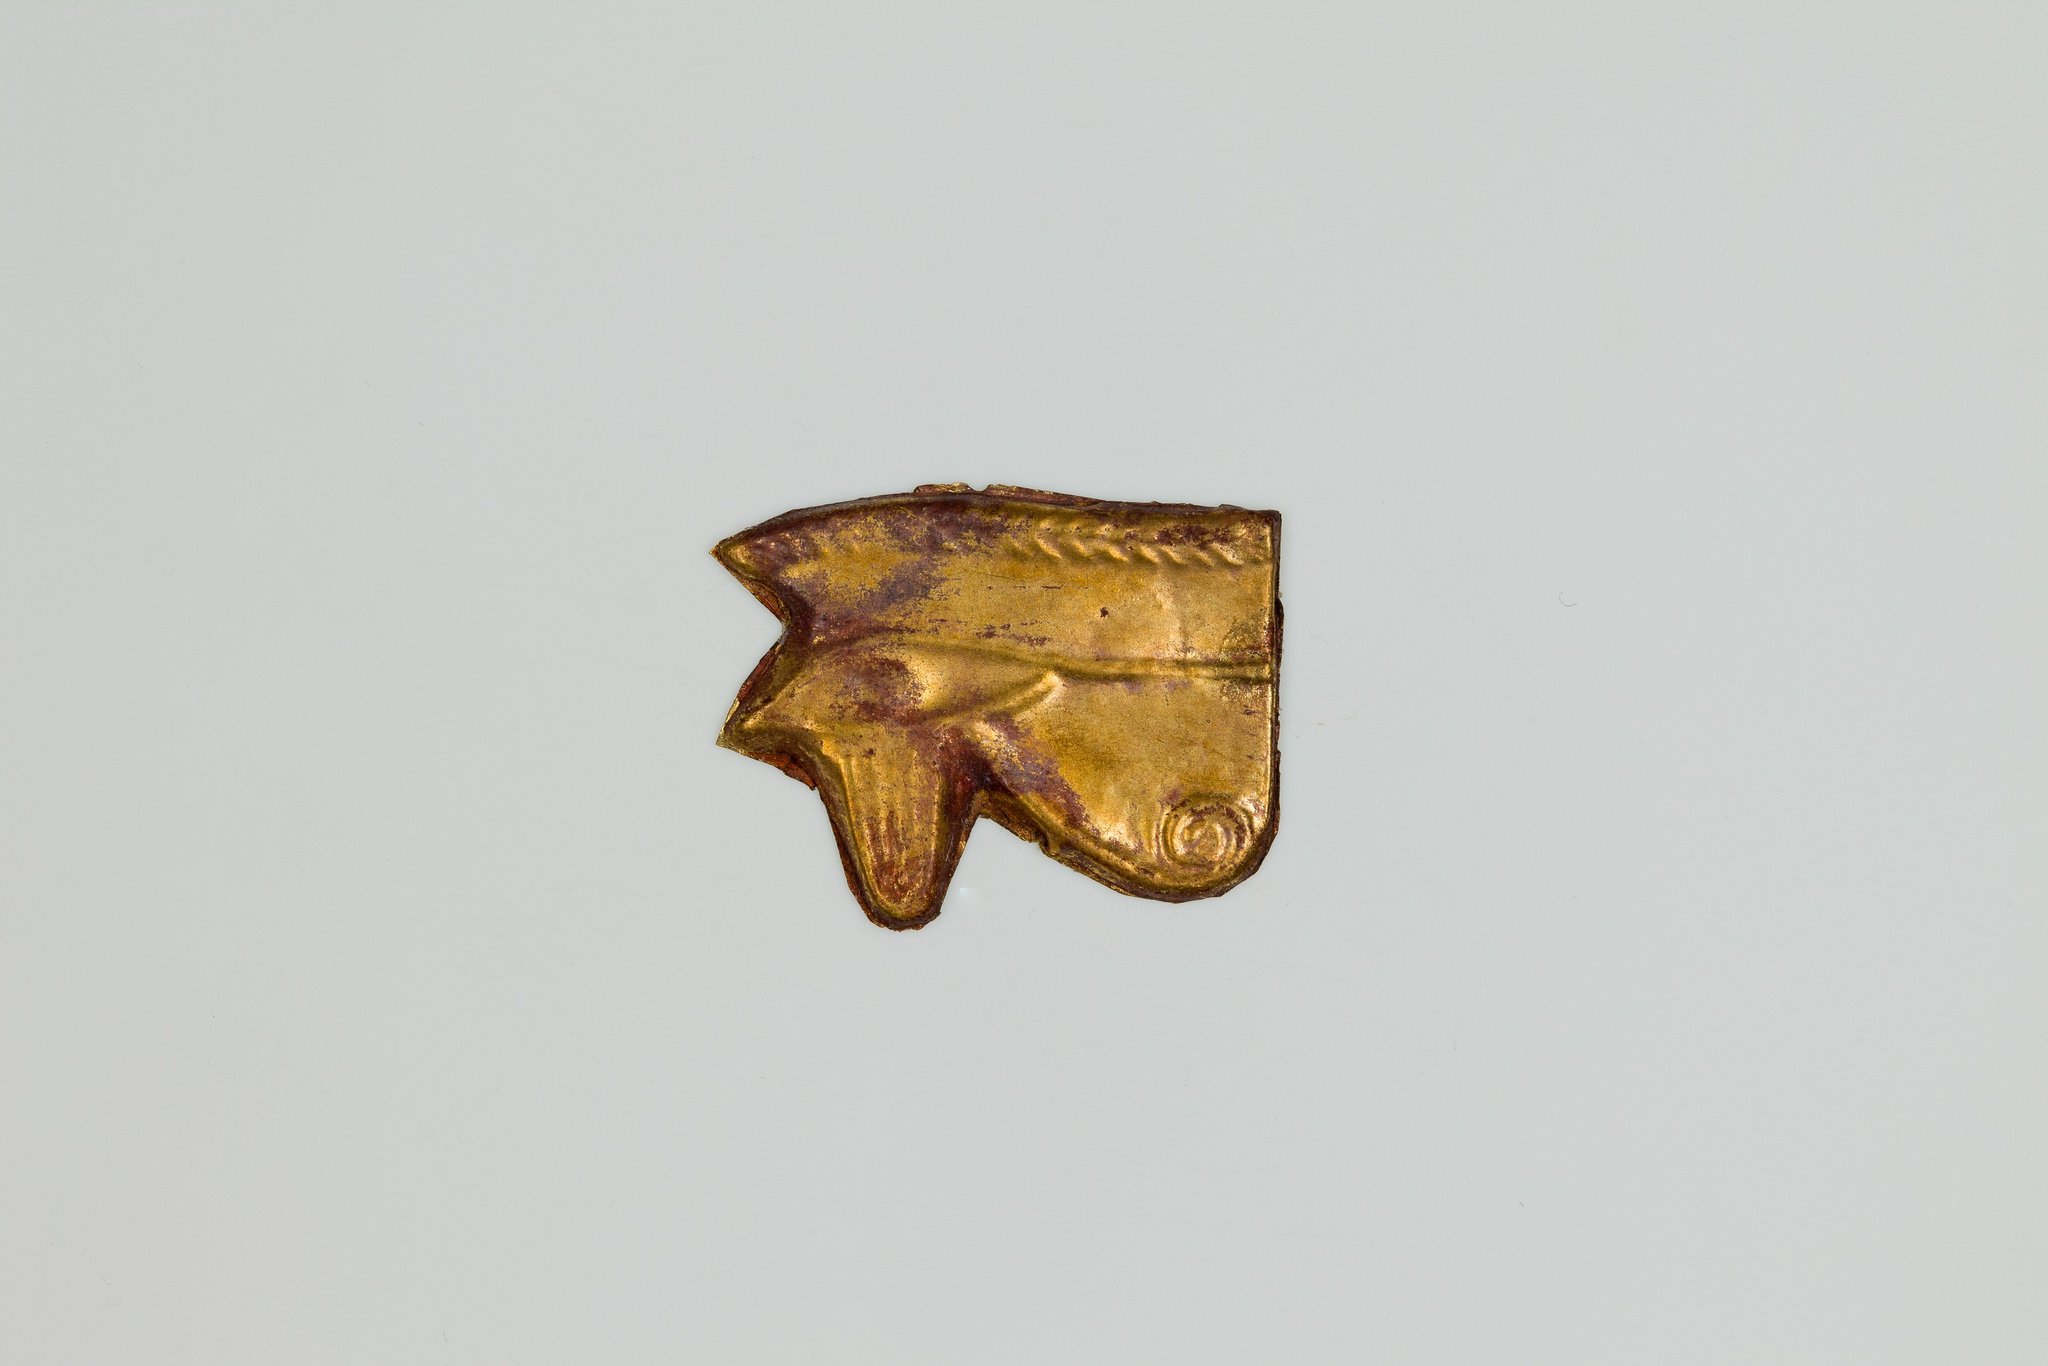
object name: amulet, wedjat eye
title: Wedjat eye amulet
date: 664-380 BCE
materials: gold